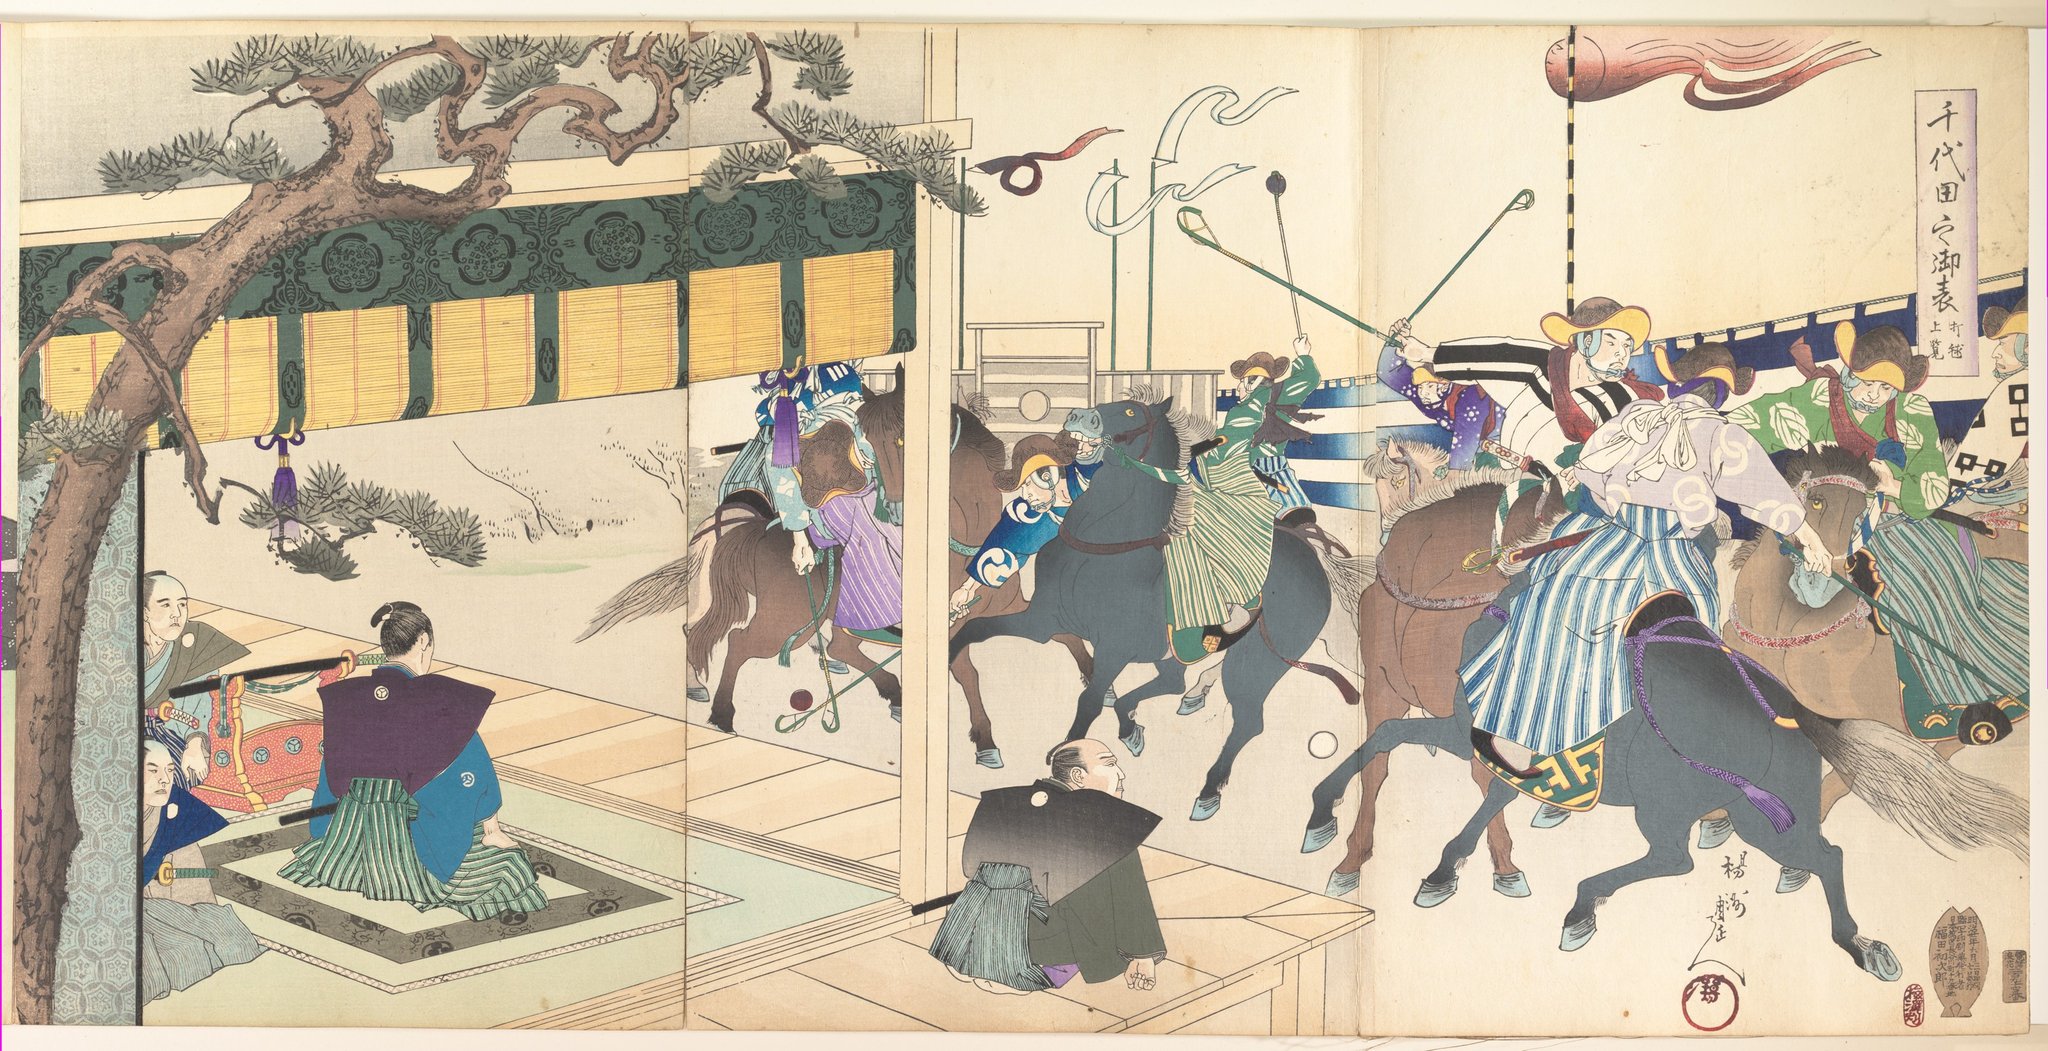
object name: print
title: Chiyoda Castle (Album of Men)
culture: japanese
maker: yōshū (hashimoto) chikanobu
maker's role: artist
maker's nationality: japanese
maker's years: 1838-1912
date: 1897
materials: ink, paper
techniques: woodblock print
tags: men,horses,trees